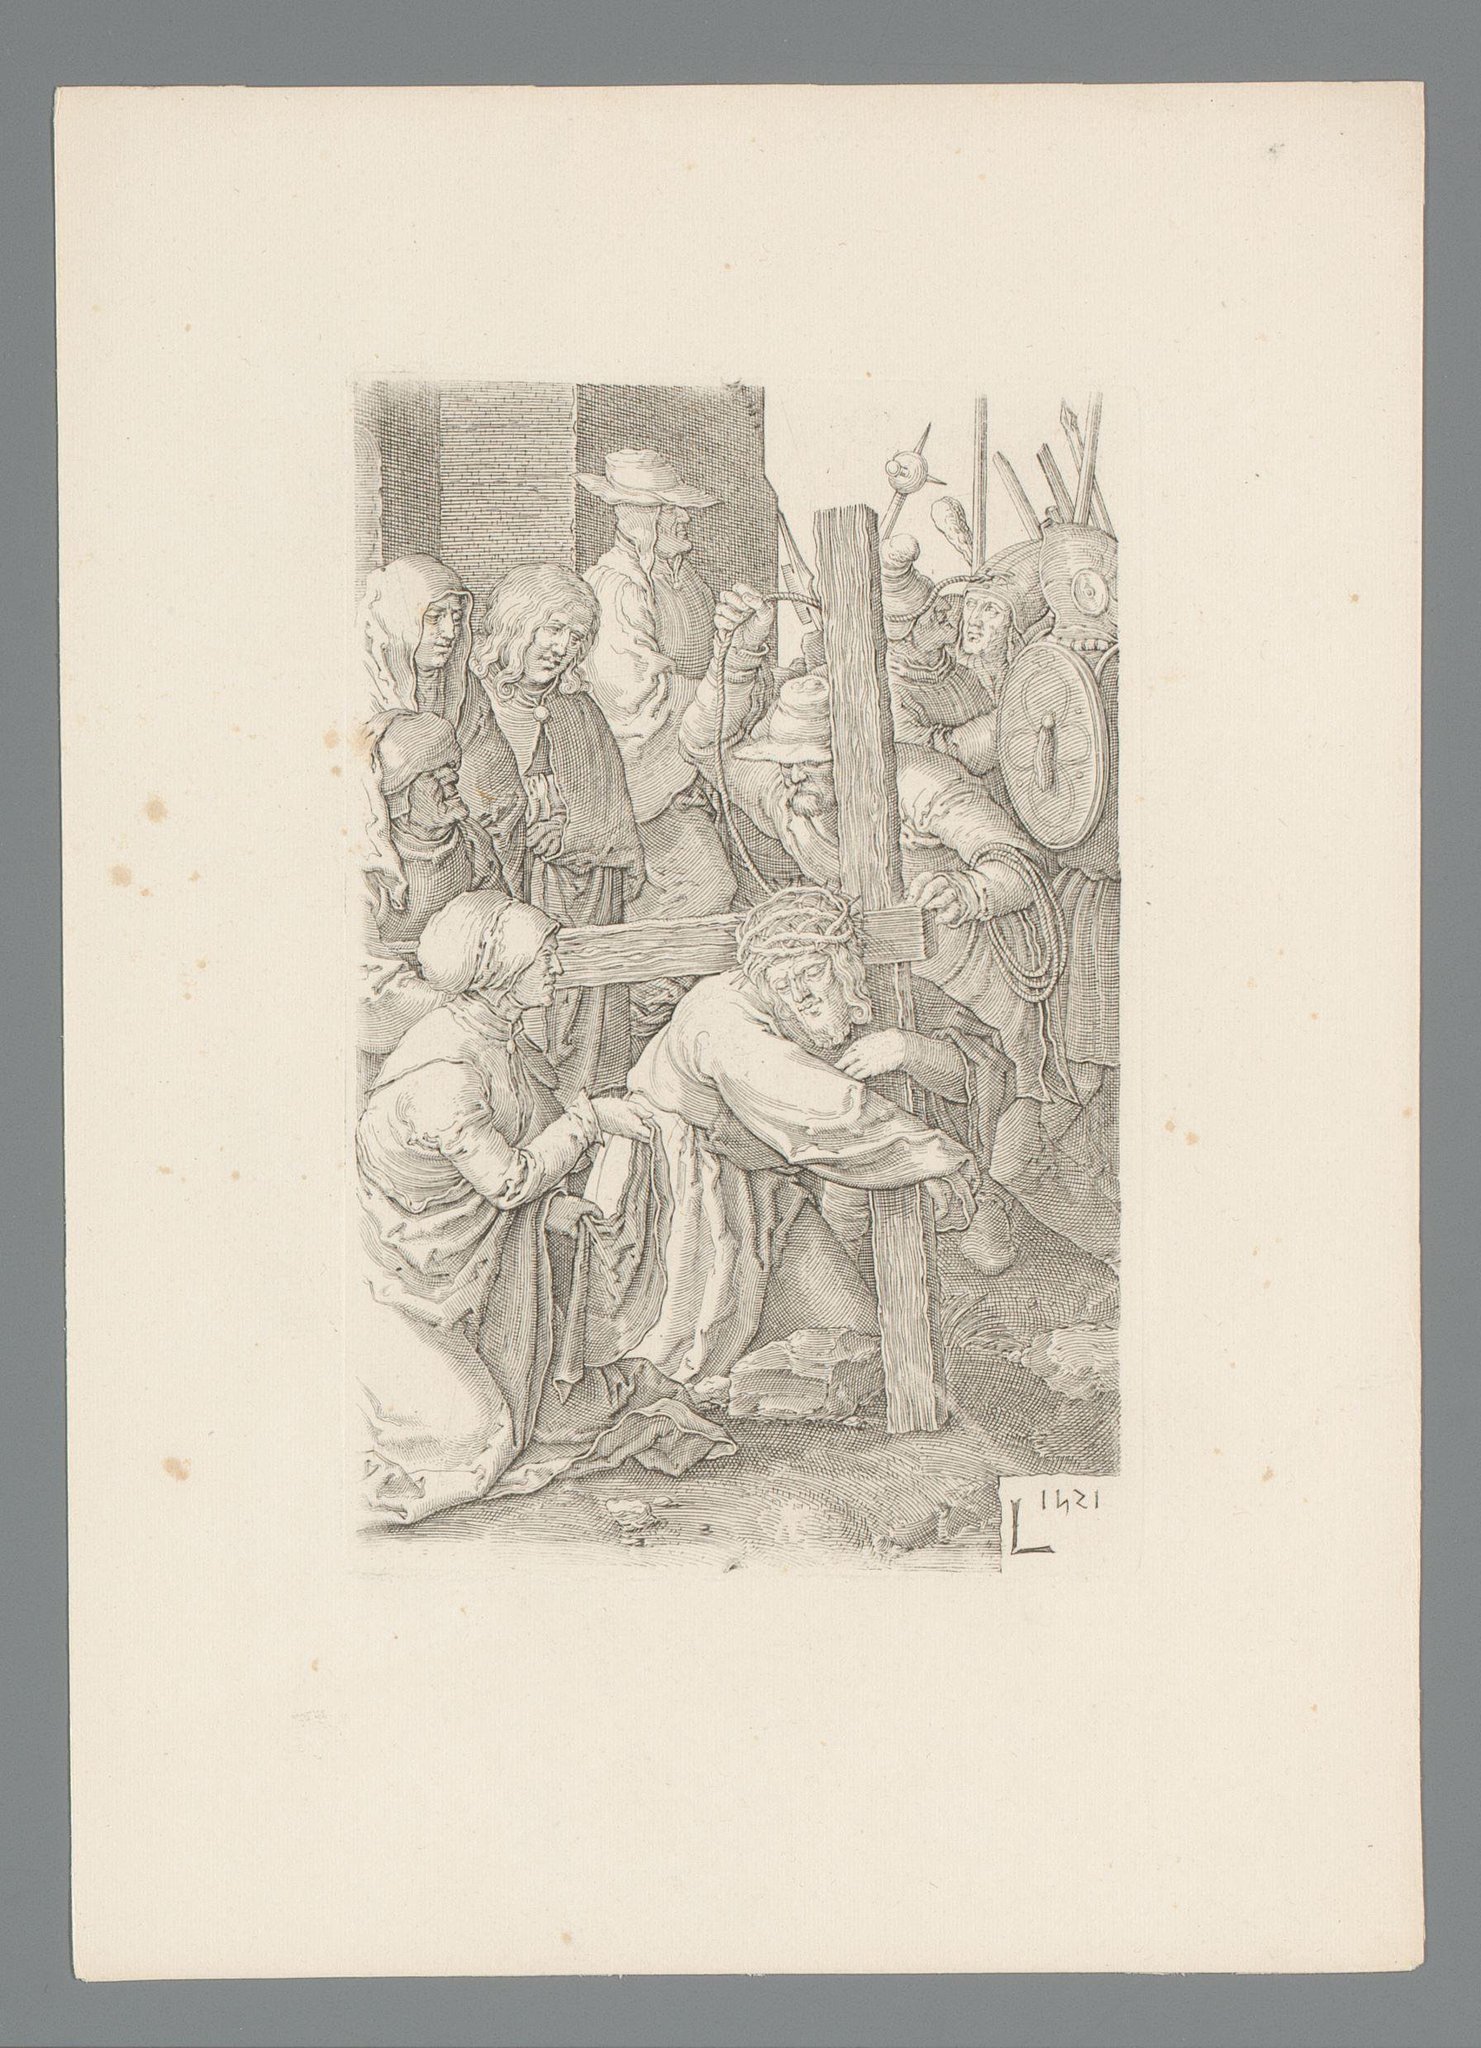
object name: print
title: Die Leiden Christi 14 Blatt. Nach Lucas von Leyden in Kupfer gestochen von J. Müller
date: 1800-1891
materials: paper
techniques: engraving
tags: carrying of the cross: christ bearing the cross, alone or with the help of others (e.g. simon the cyrenian)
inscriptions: collector's mark: Lugt 2227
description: Maakt deel uit van een serie die in de negentiende eeuw is herdrukt met de titel: Die Leiden Christi 14 Blatt. Nach Lucas von Leyden in Kupfer gestochen von J. Müller.